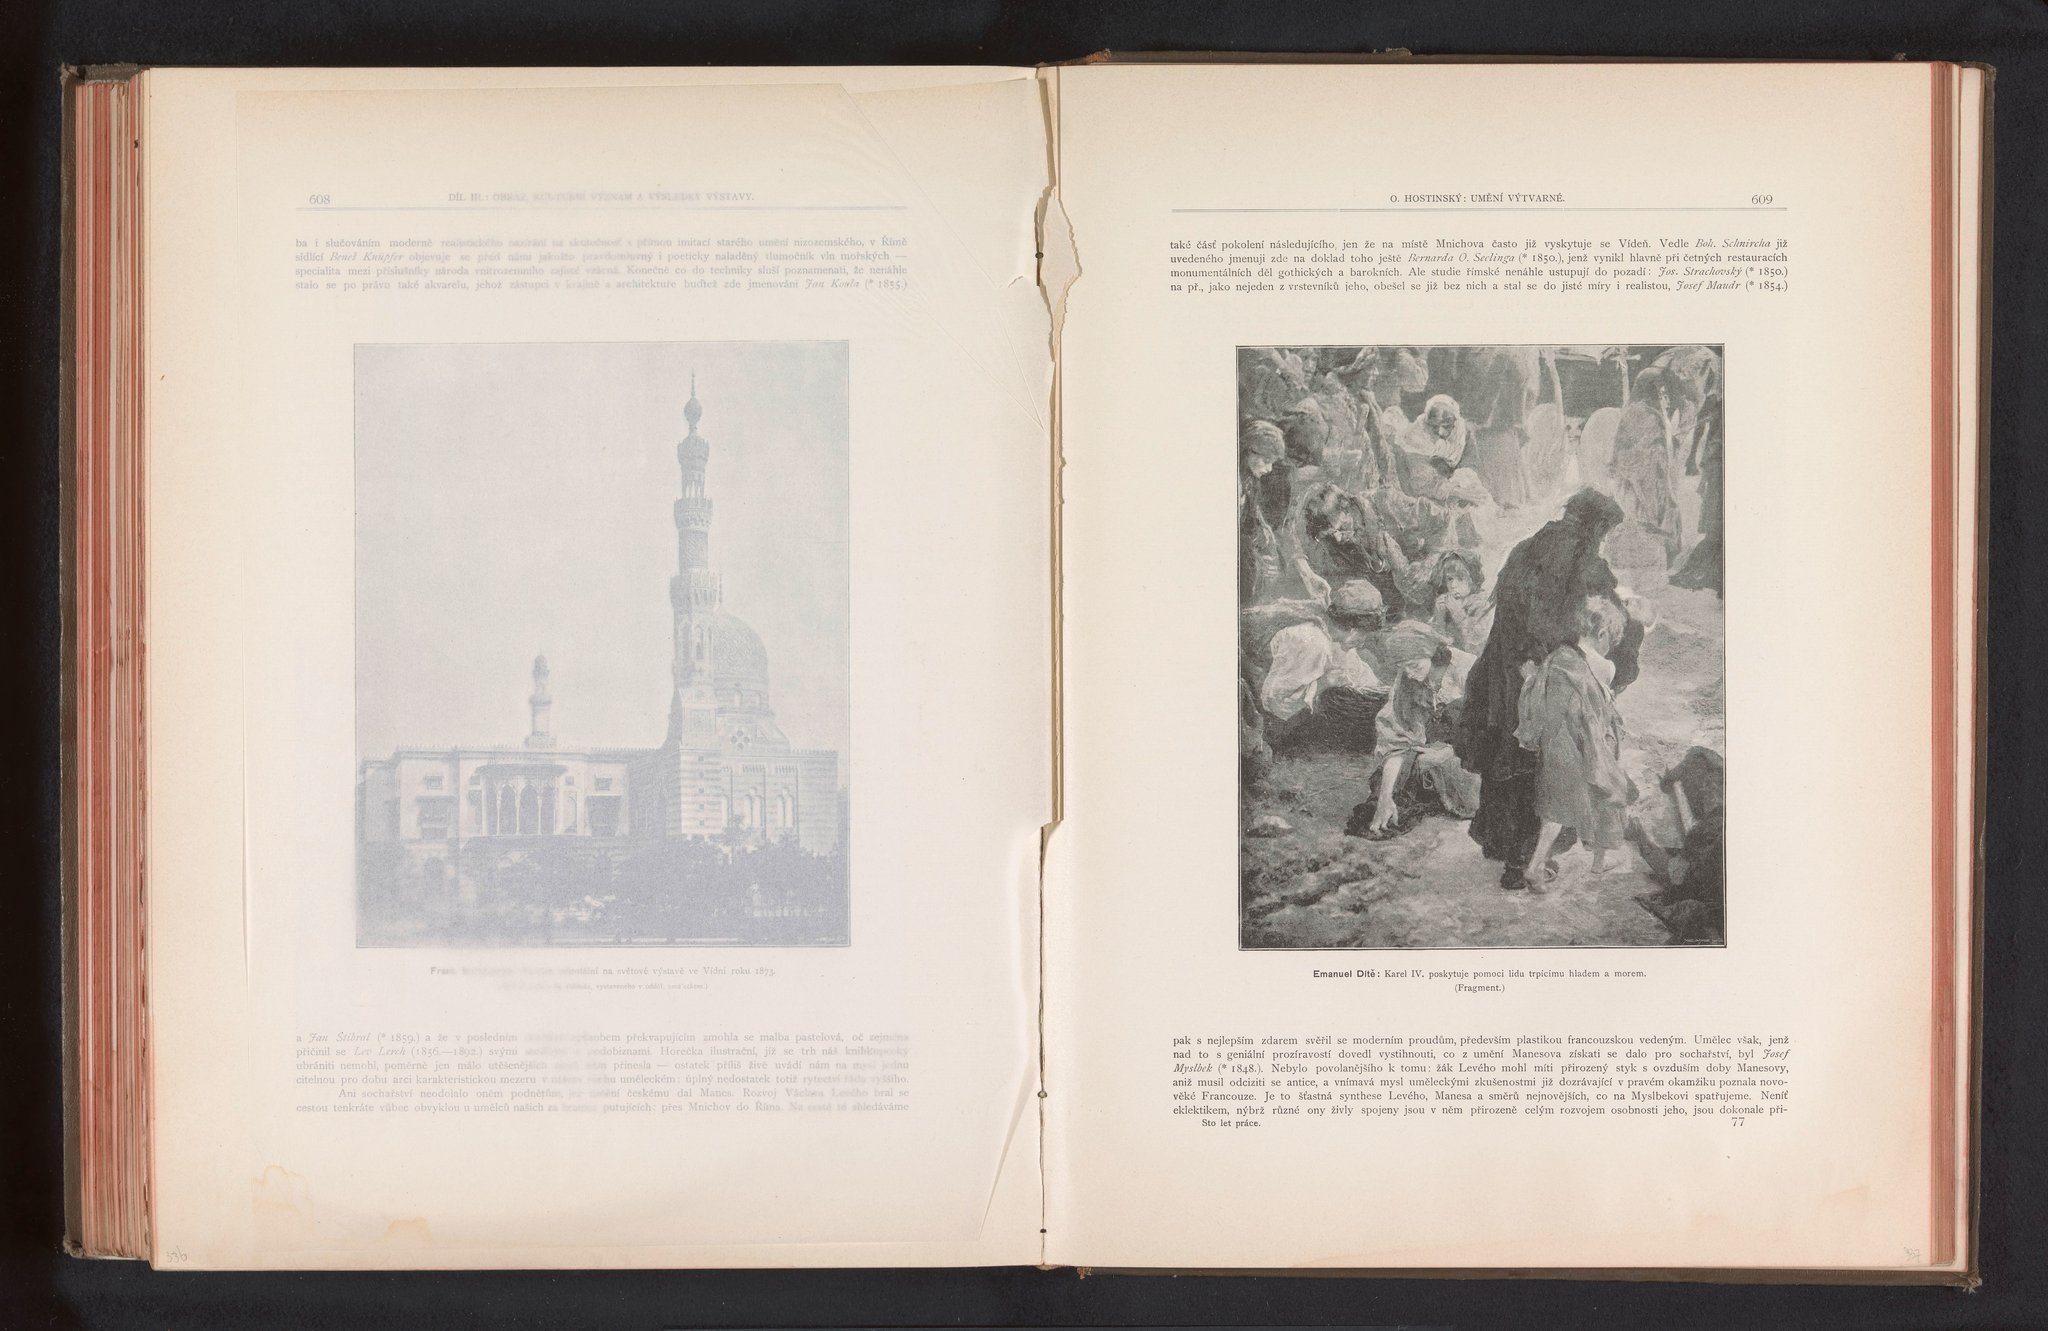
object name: photomechanical print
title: Fotoreproductie van een schilderij, voorstellende keizer Karel IV biedt hulp aan hongerlijders en pestlijders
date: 1891-1895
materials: paper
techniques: autotype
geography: prague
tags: emperor, starvation, famine